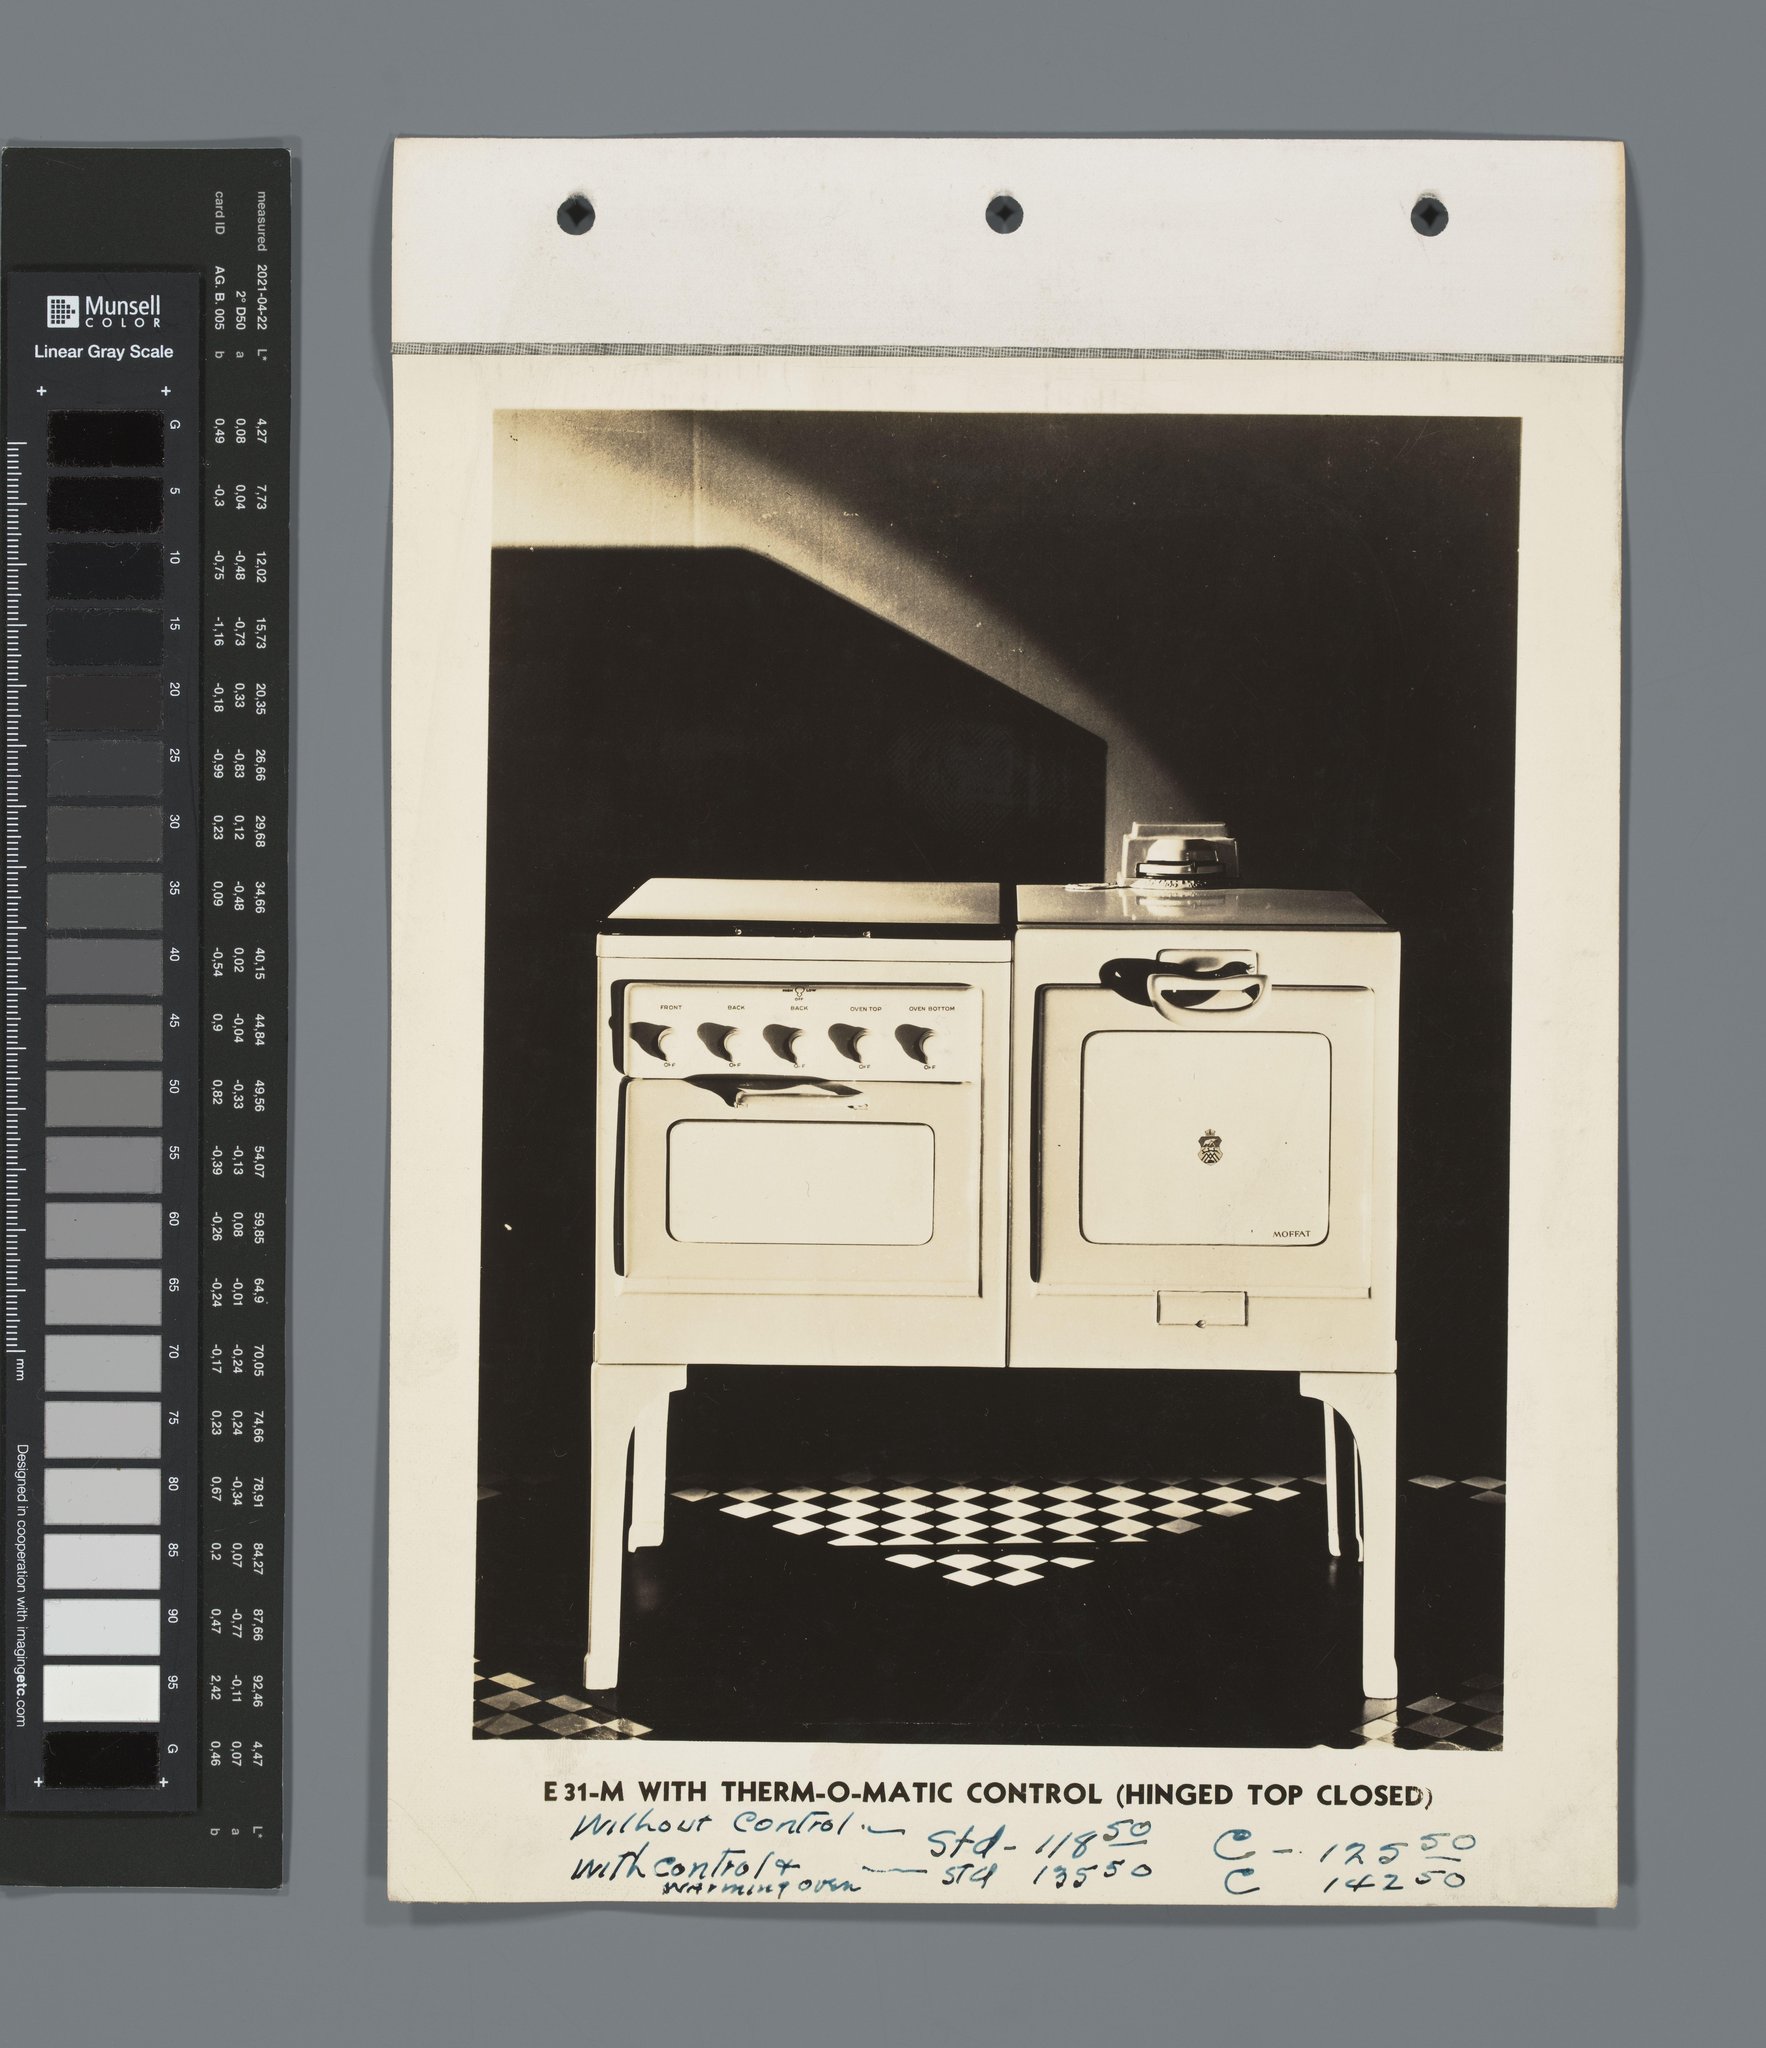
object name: photograph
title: Foto van Moffat ovens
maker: Anonymous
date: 1935-1940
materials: paper, photographic support, textile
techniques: gelatin silver print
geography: canada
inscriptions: inscription: ‘Without control - Std - 11850 C-12550’, inscription: ‘E 31-M WITH THERM-O-MATIC CONTROL (HINGED TOP CLOSED)’, inscription: ‘With control + warming oven - Std 13550, C 14250’